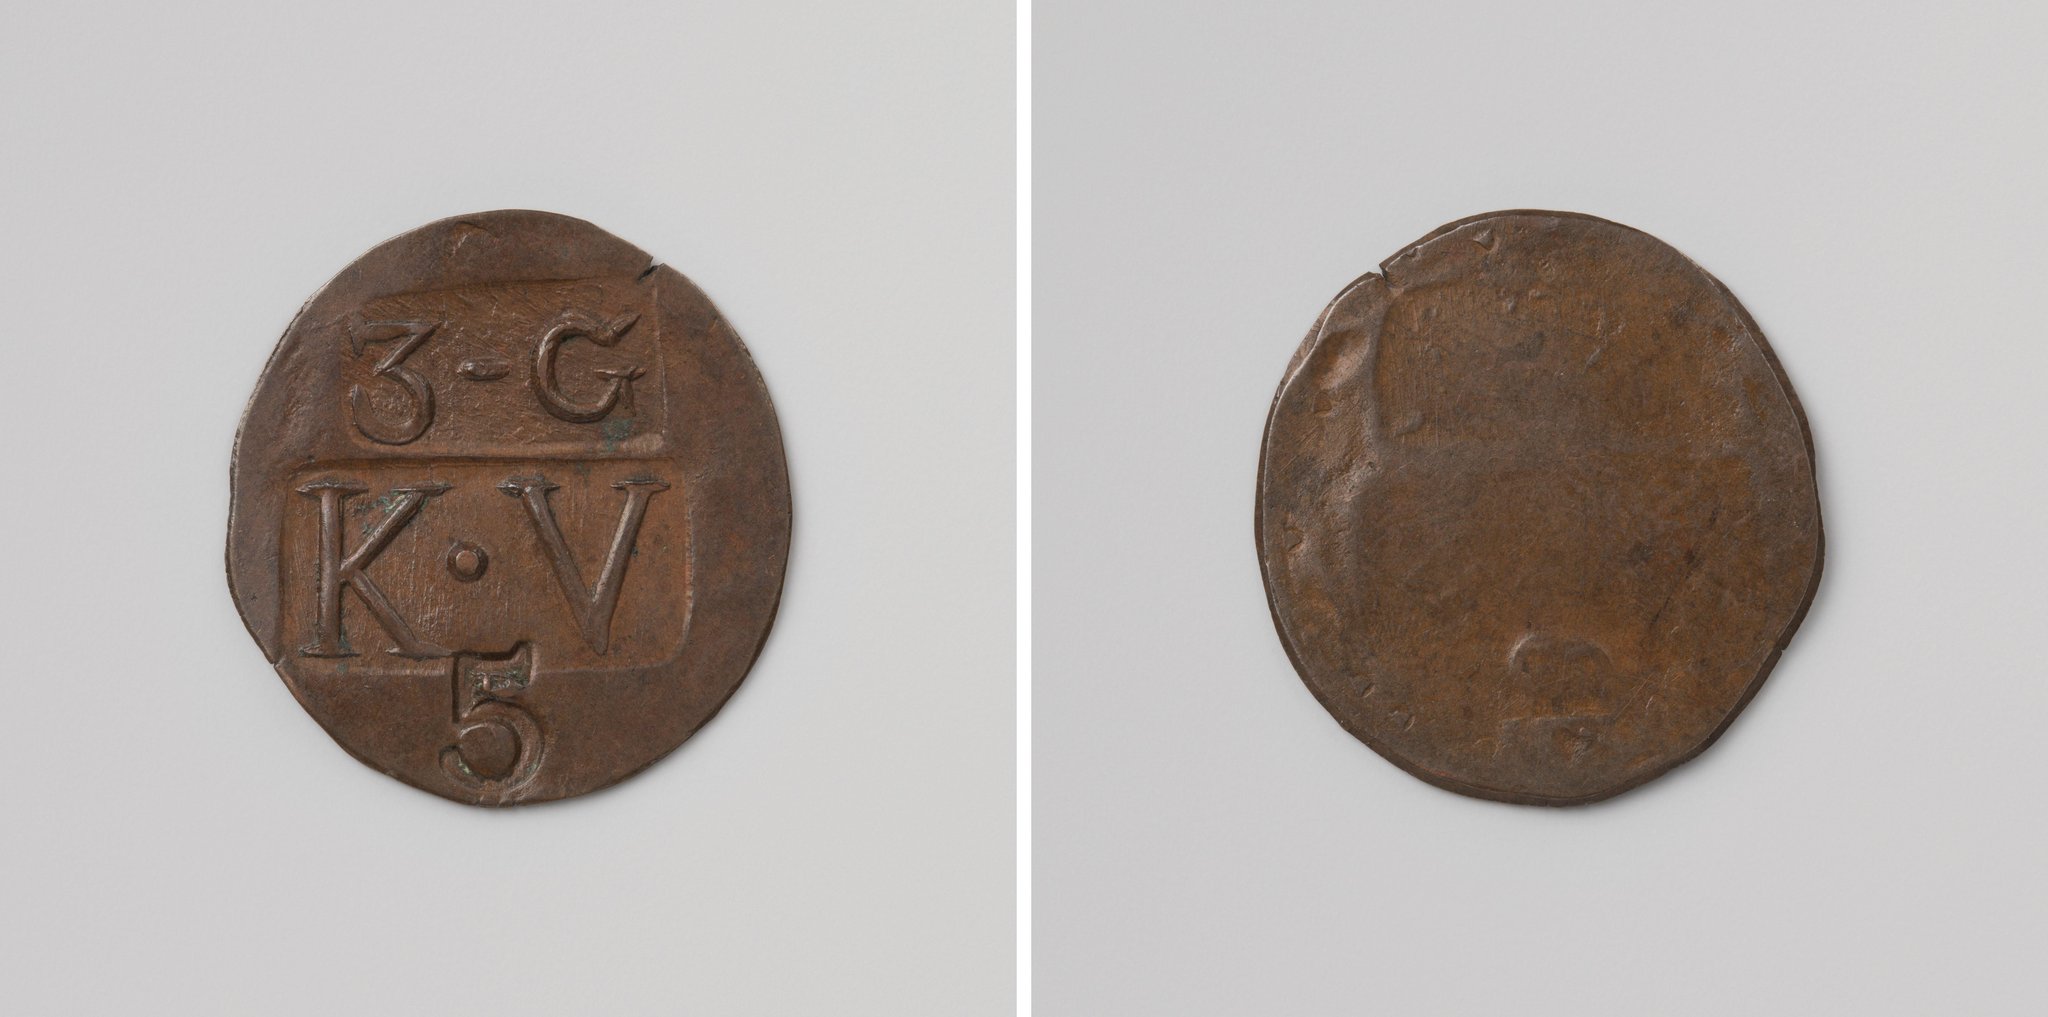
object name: huismunt prison money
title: Derde gesticht van de kolonie Veenhuizen, huismunt geslagen op last van de Maatschappij van Weldadigheid ter waarde van vijf cent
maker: Anonymous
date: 1818-1859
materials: copper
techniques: striking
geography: netherlands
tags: maatschappij van weldadigheid, veenhuizen